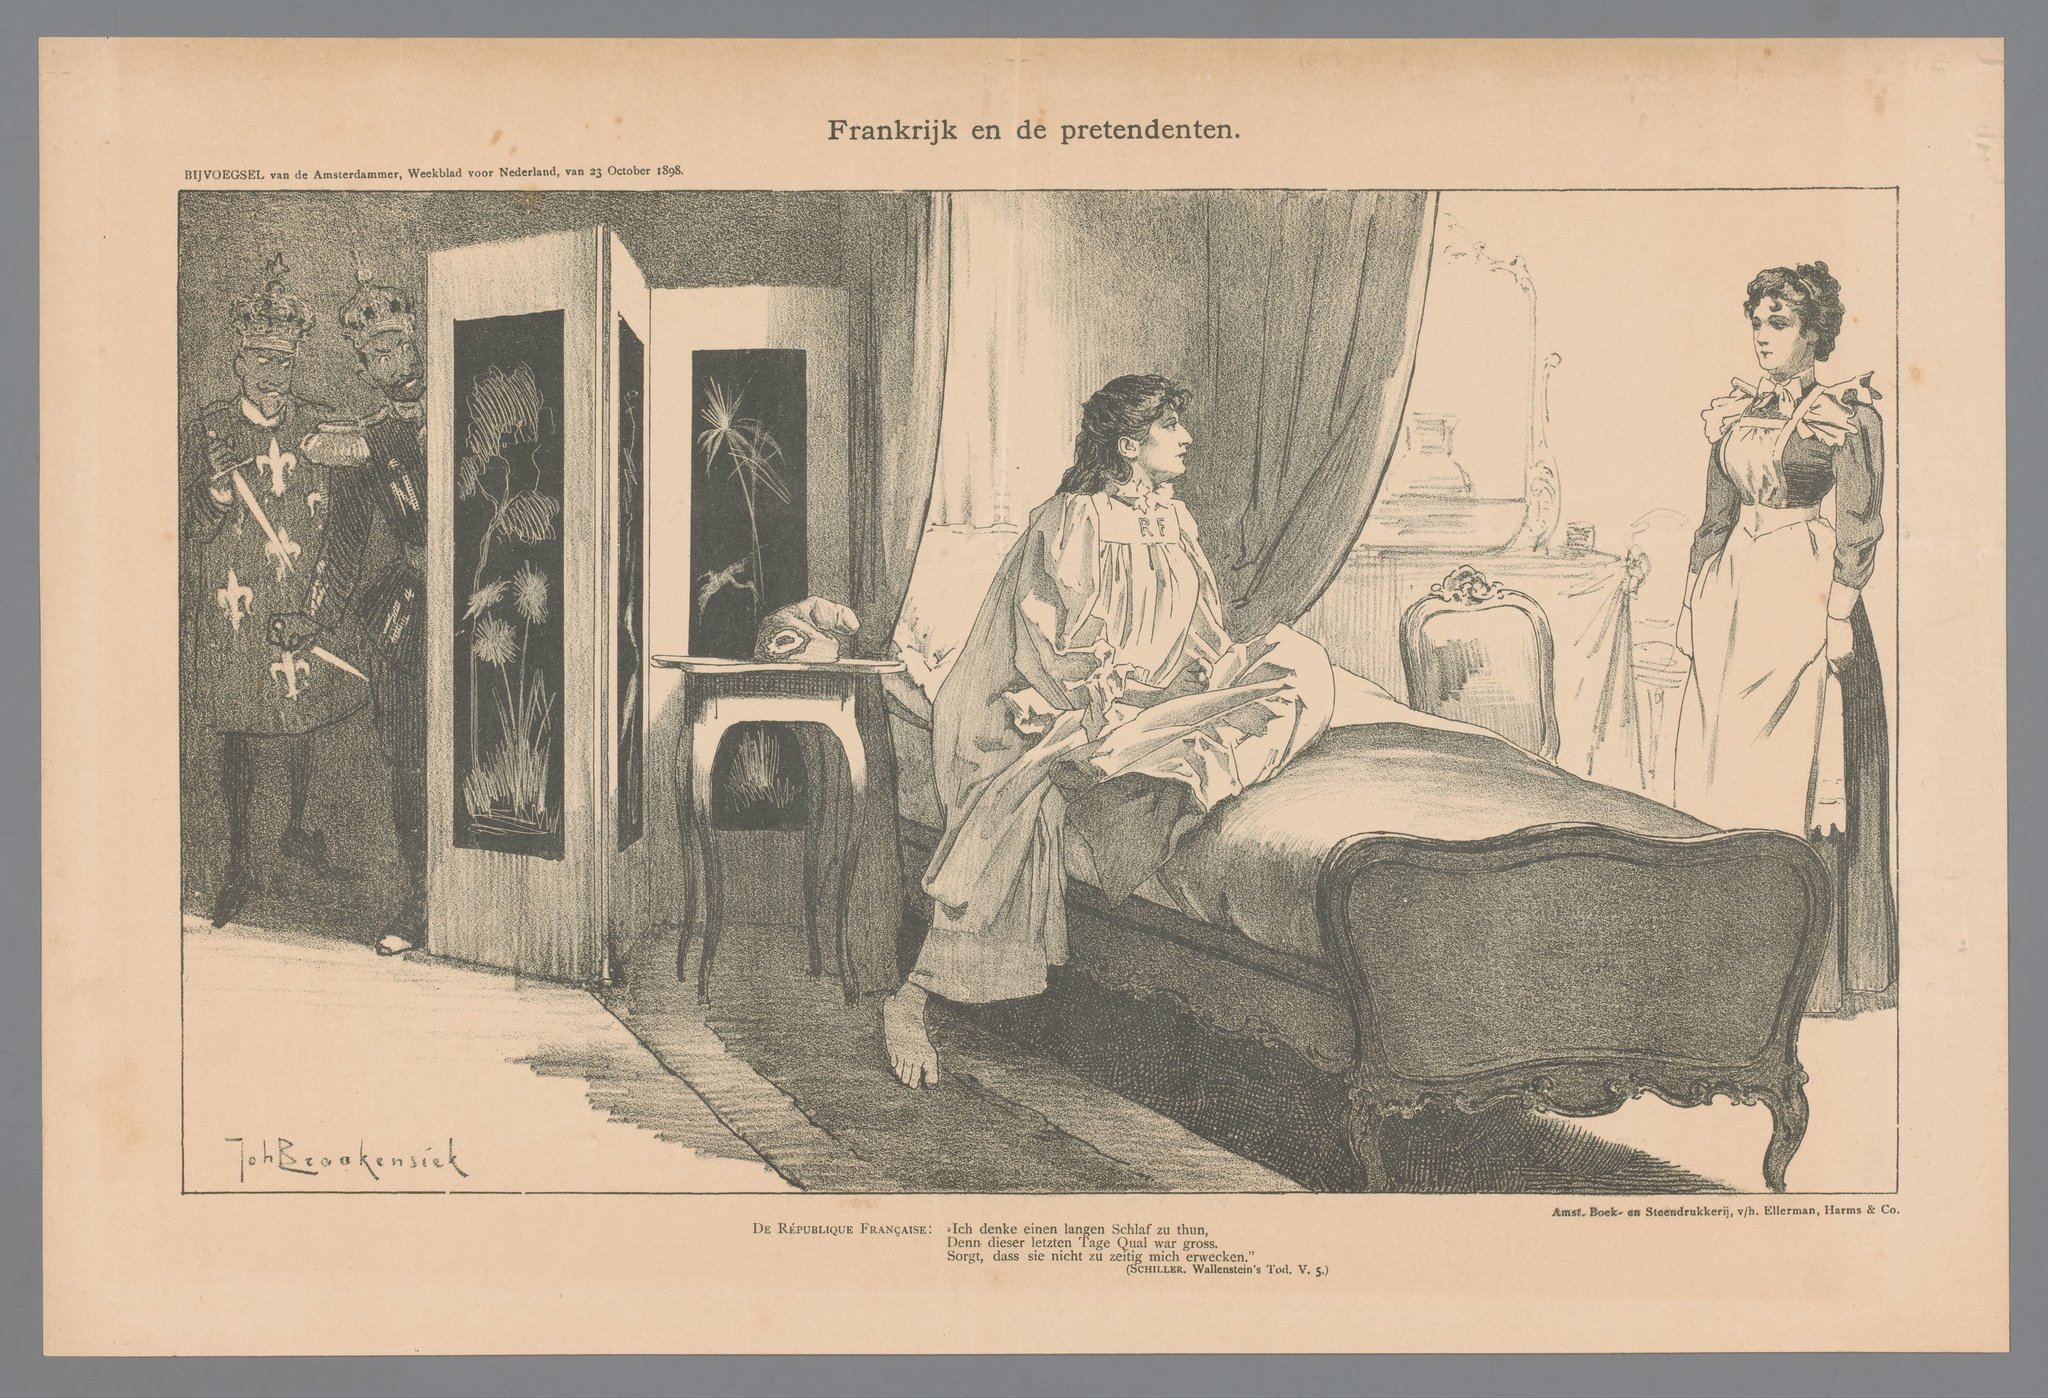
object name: cartoon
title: Frankrijk en de pretendenten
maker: johan braakensiek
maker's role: draughtsman, print maker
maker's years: 1858-1940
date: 1898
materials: paper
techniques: lithograph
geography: amsterdam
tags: going to sleep, historical persons, personifications of countries, nations, states, districts, etc. (+ nation; national), maid ~ house personnel, political caricatures and satires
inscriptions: date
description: Prent uit het bijvoegsel van: De Amsterdammer. Weekblad voor Nederland, 23 oktober 1898.